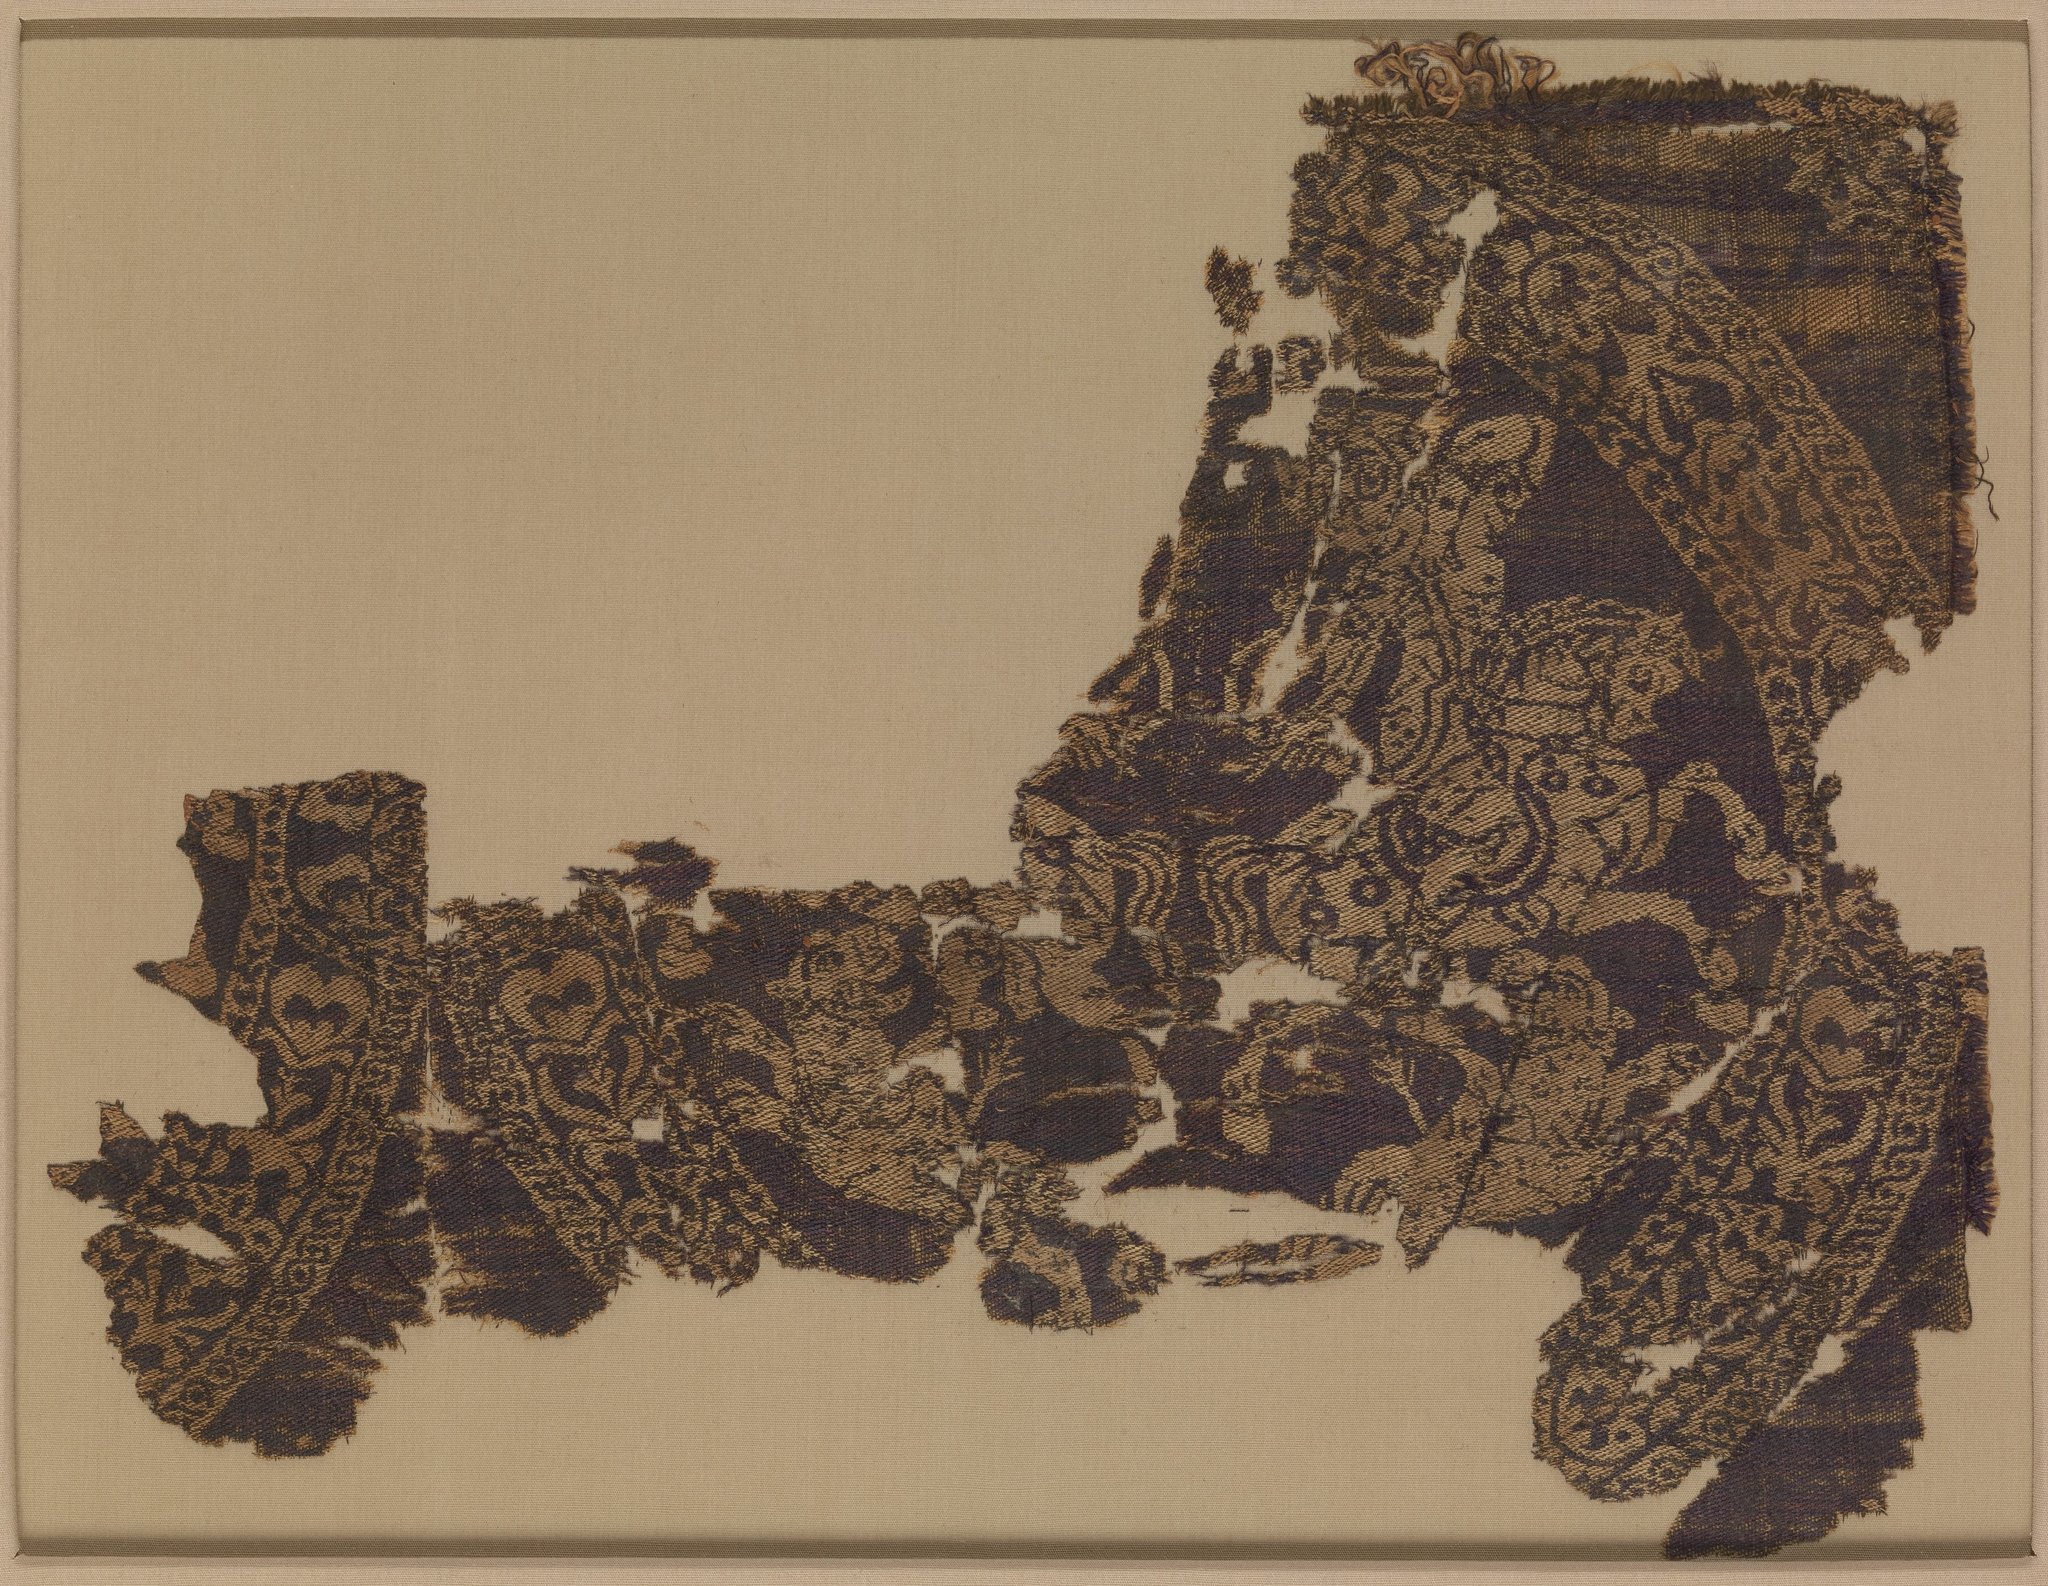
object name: textile fragment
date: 701-800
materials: silk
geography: egypt or syria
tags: horses